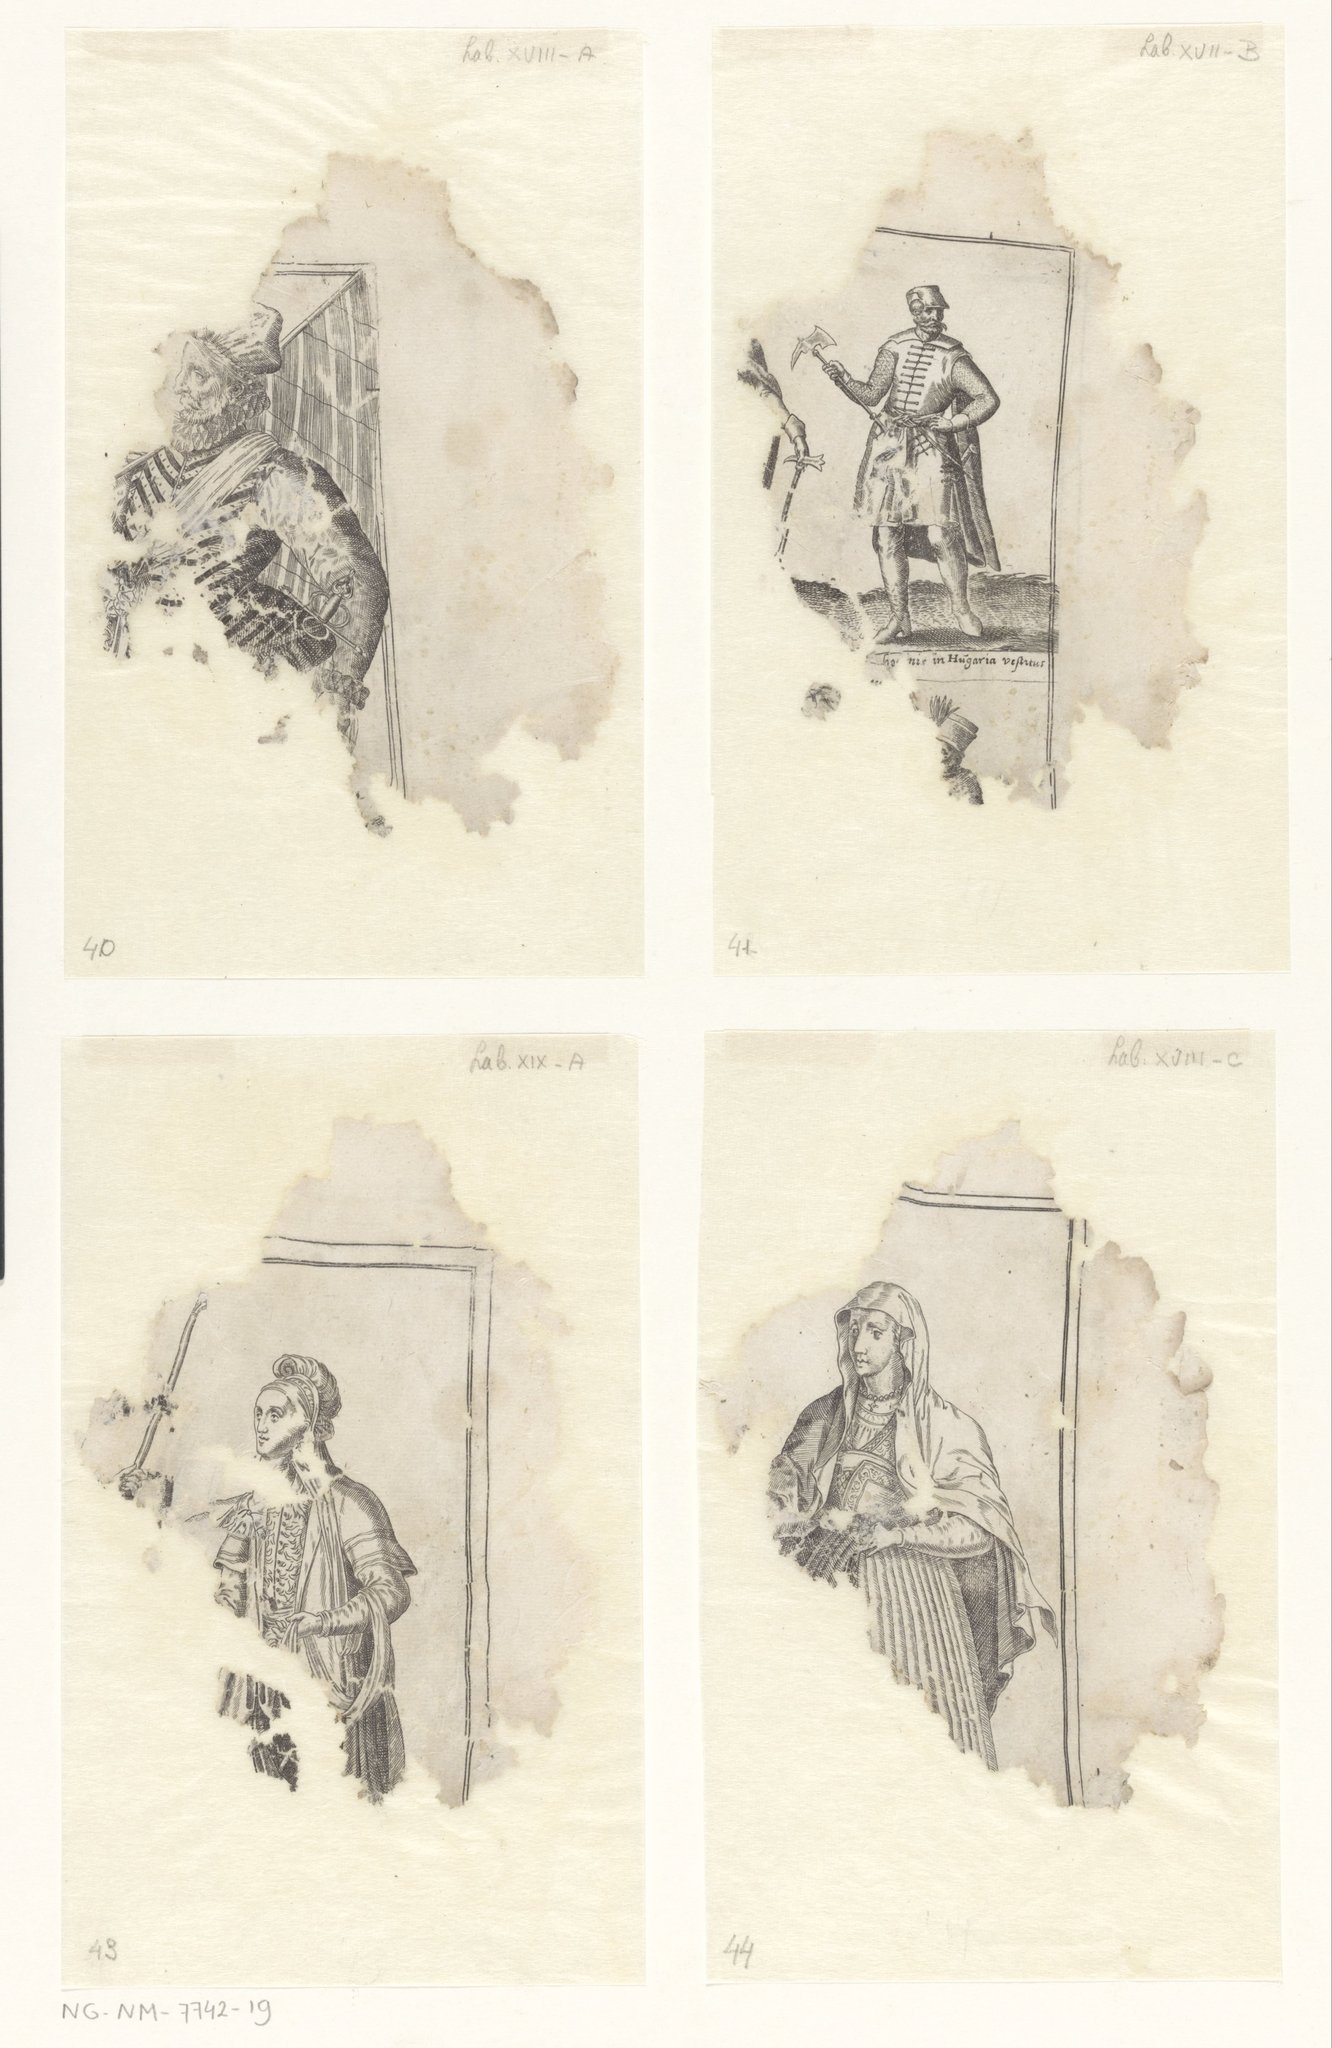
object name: costume print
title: Omnium pene Europae, Asiae, Aphricae atque Americae gentium habitus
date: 1581-1596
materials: paper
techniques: engraving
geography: cologne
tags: clothes, costume (+ women's clothes), clothes, costume (+ men's clothes)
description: De prenten in de Nova Zembla collectie zijn tijdens een expeditie van Willem Barendsz en Jacob van Heemskerk in 1596-1597 noodgedwongen in het winterkamp, het ‘Behouden Huis’, op het eiland achtergelaten. De prenten waren in één of meerdere stapels als handelswaar meegenomen vanuit Amsterdam. Bijna drie eeuwen later, in 1871, keerde de Noor Elling Carlsen terug naar Nova Zembla en vond daar de restanten van het ‘Behouden Huis, inclusief een groot deel van de inventaris. Een deel van de prenten, in de vorm van aaneengekoekte kluiten, werd toen ook teruggevonden. De papierkluiten waren soms op meerdere plekken gebroken. Tussen 1975-1979 zijn de prenten van elkaar gescheiden. Dit leverde in totaal ca. 1000 fragmenten van ca. 400 afdrukken van ca. 150 verschillende prenten op. Voor zover mogelijk zijn de fragmenten samengevoegd en zijn de prenten gereconstrueerd.